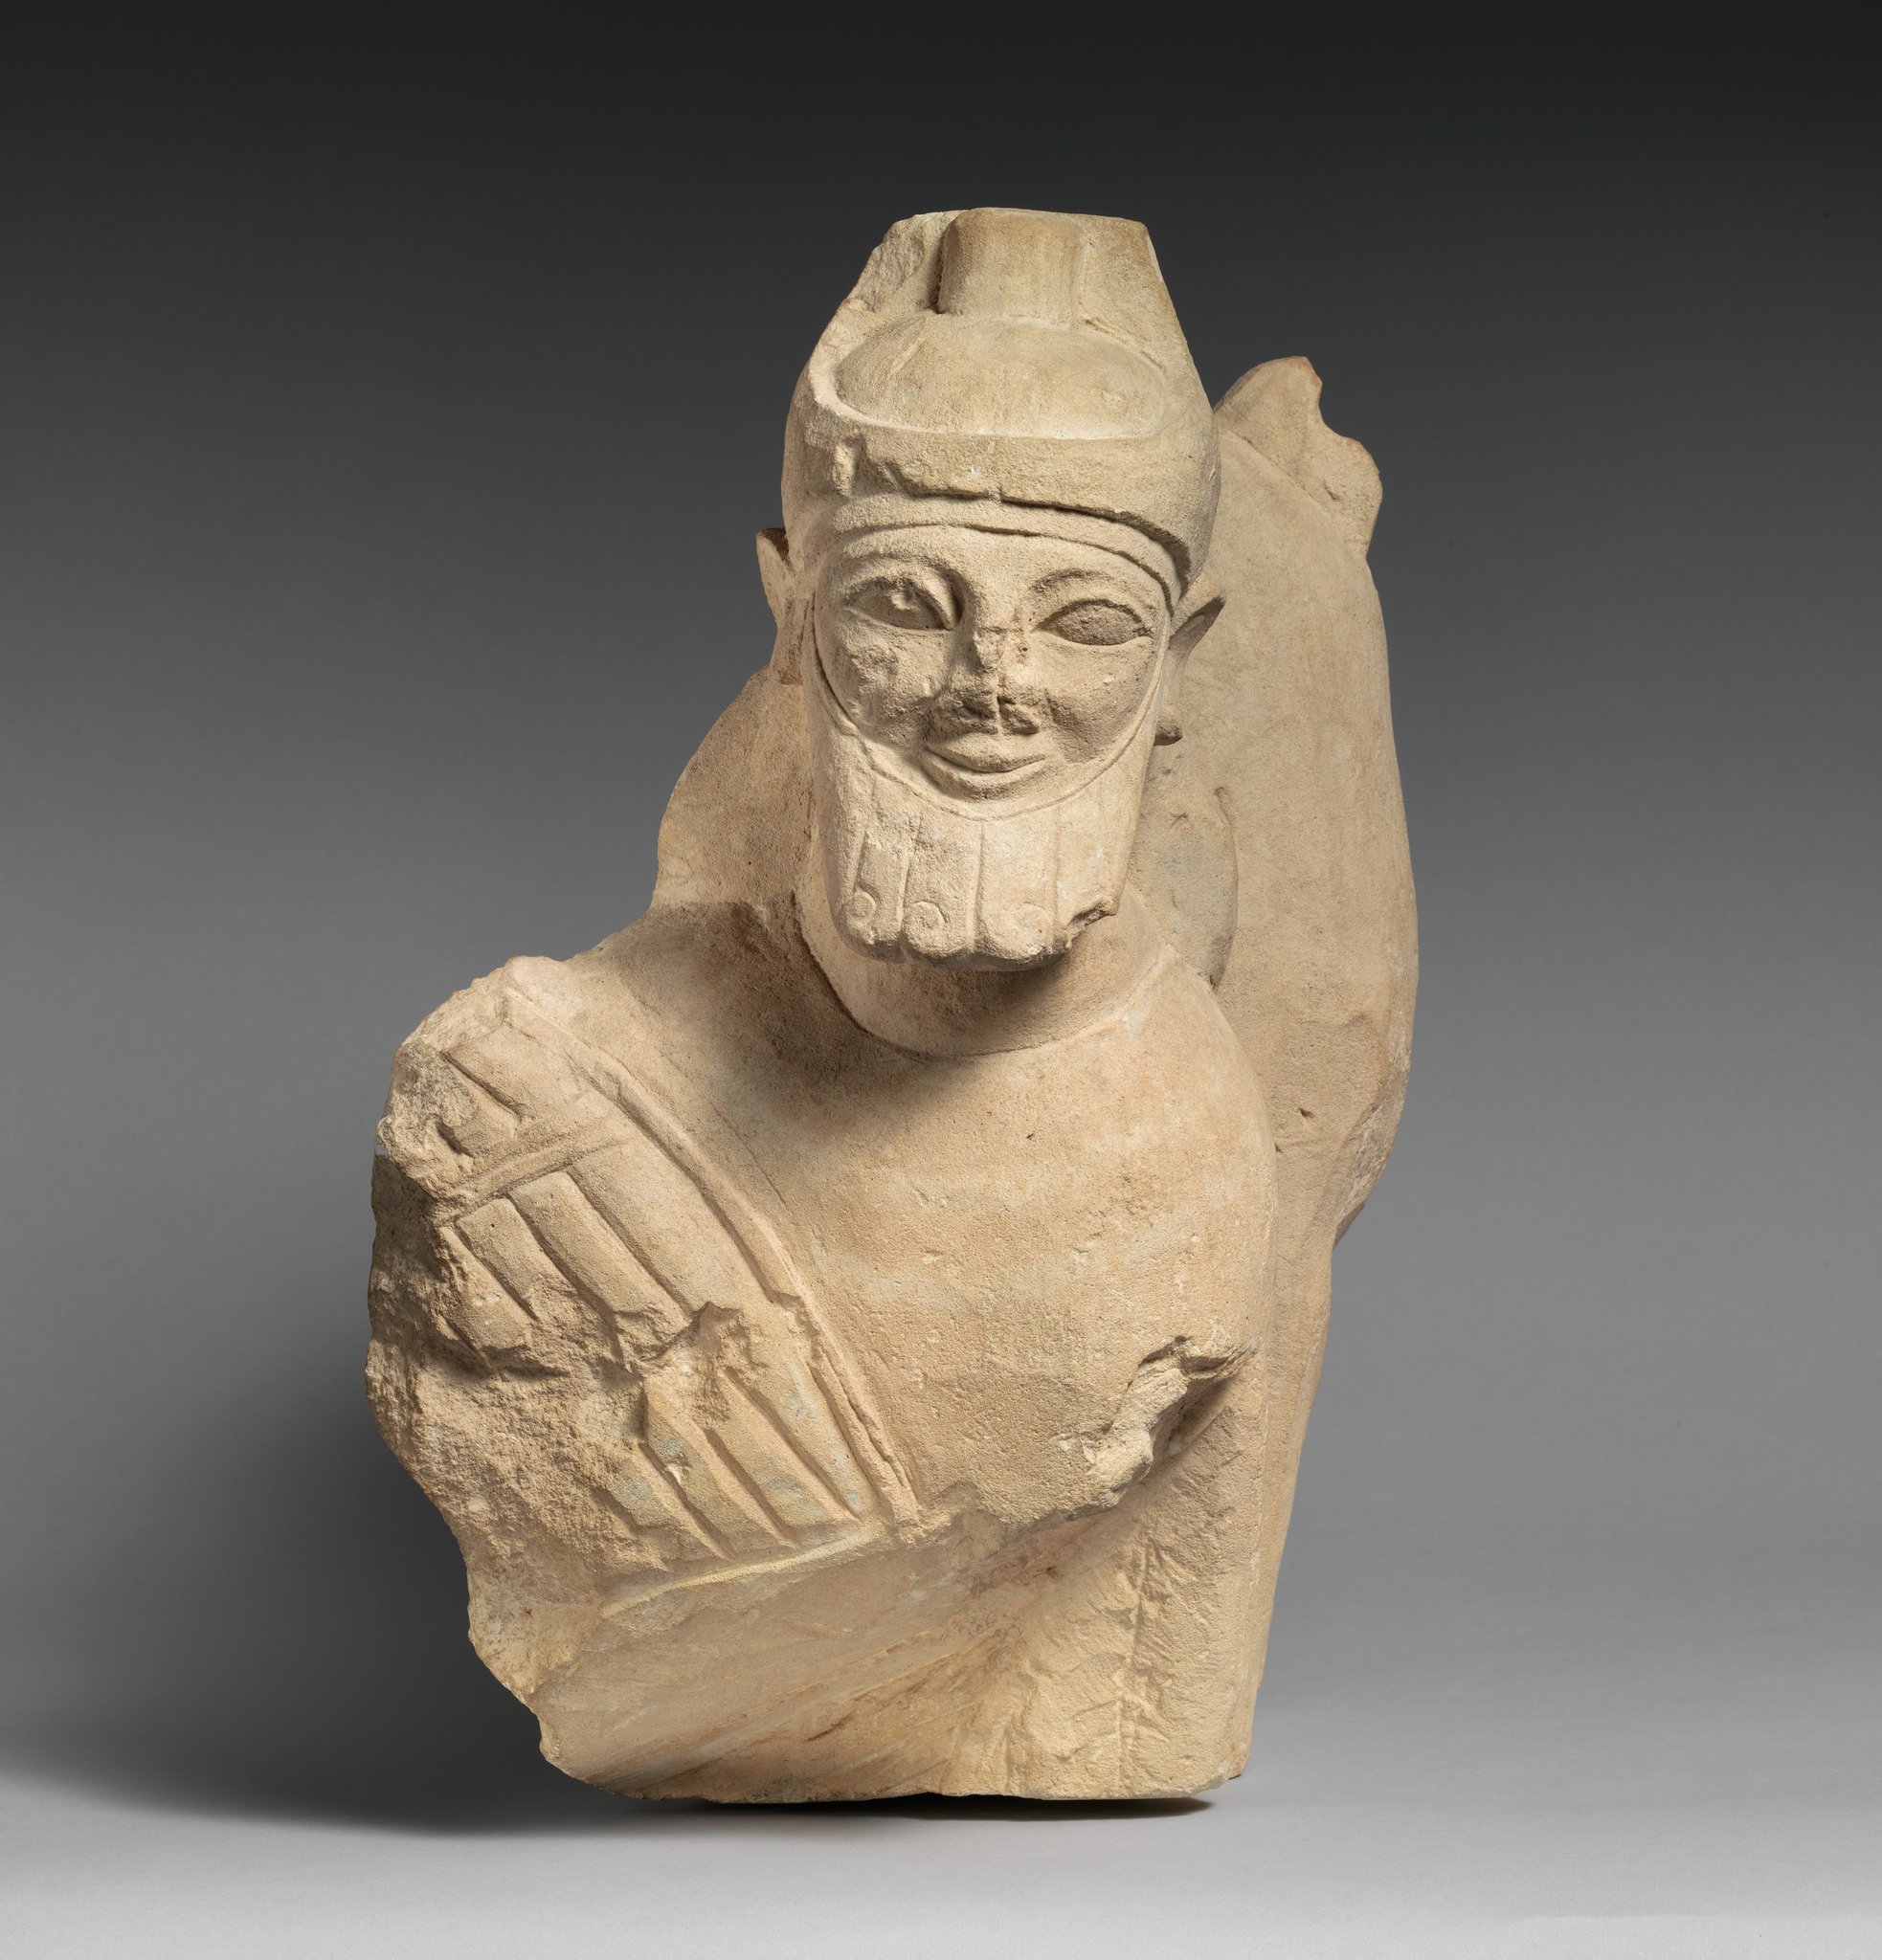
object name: cippus with human headed bull and sphinx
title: Limestone finial of a votive stele (?) with a lion and a male sphinx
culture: cypriot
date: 575-525 BCE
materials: limestone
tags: sphinx,lions